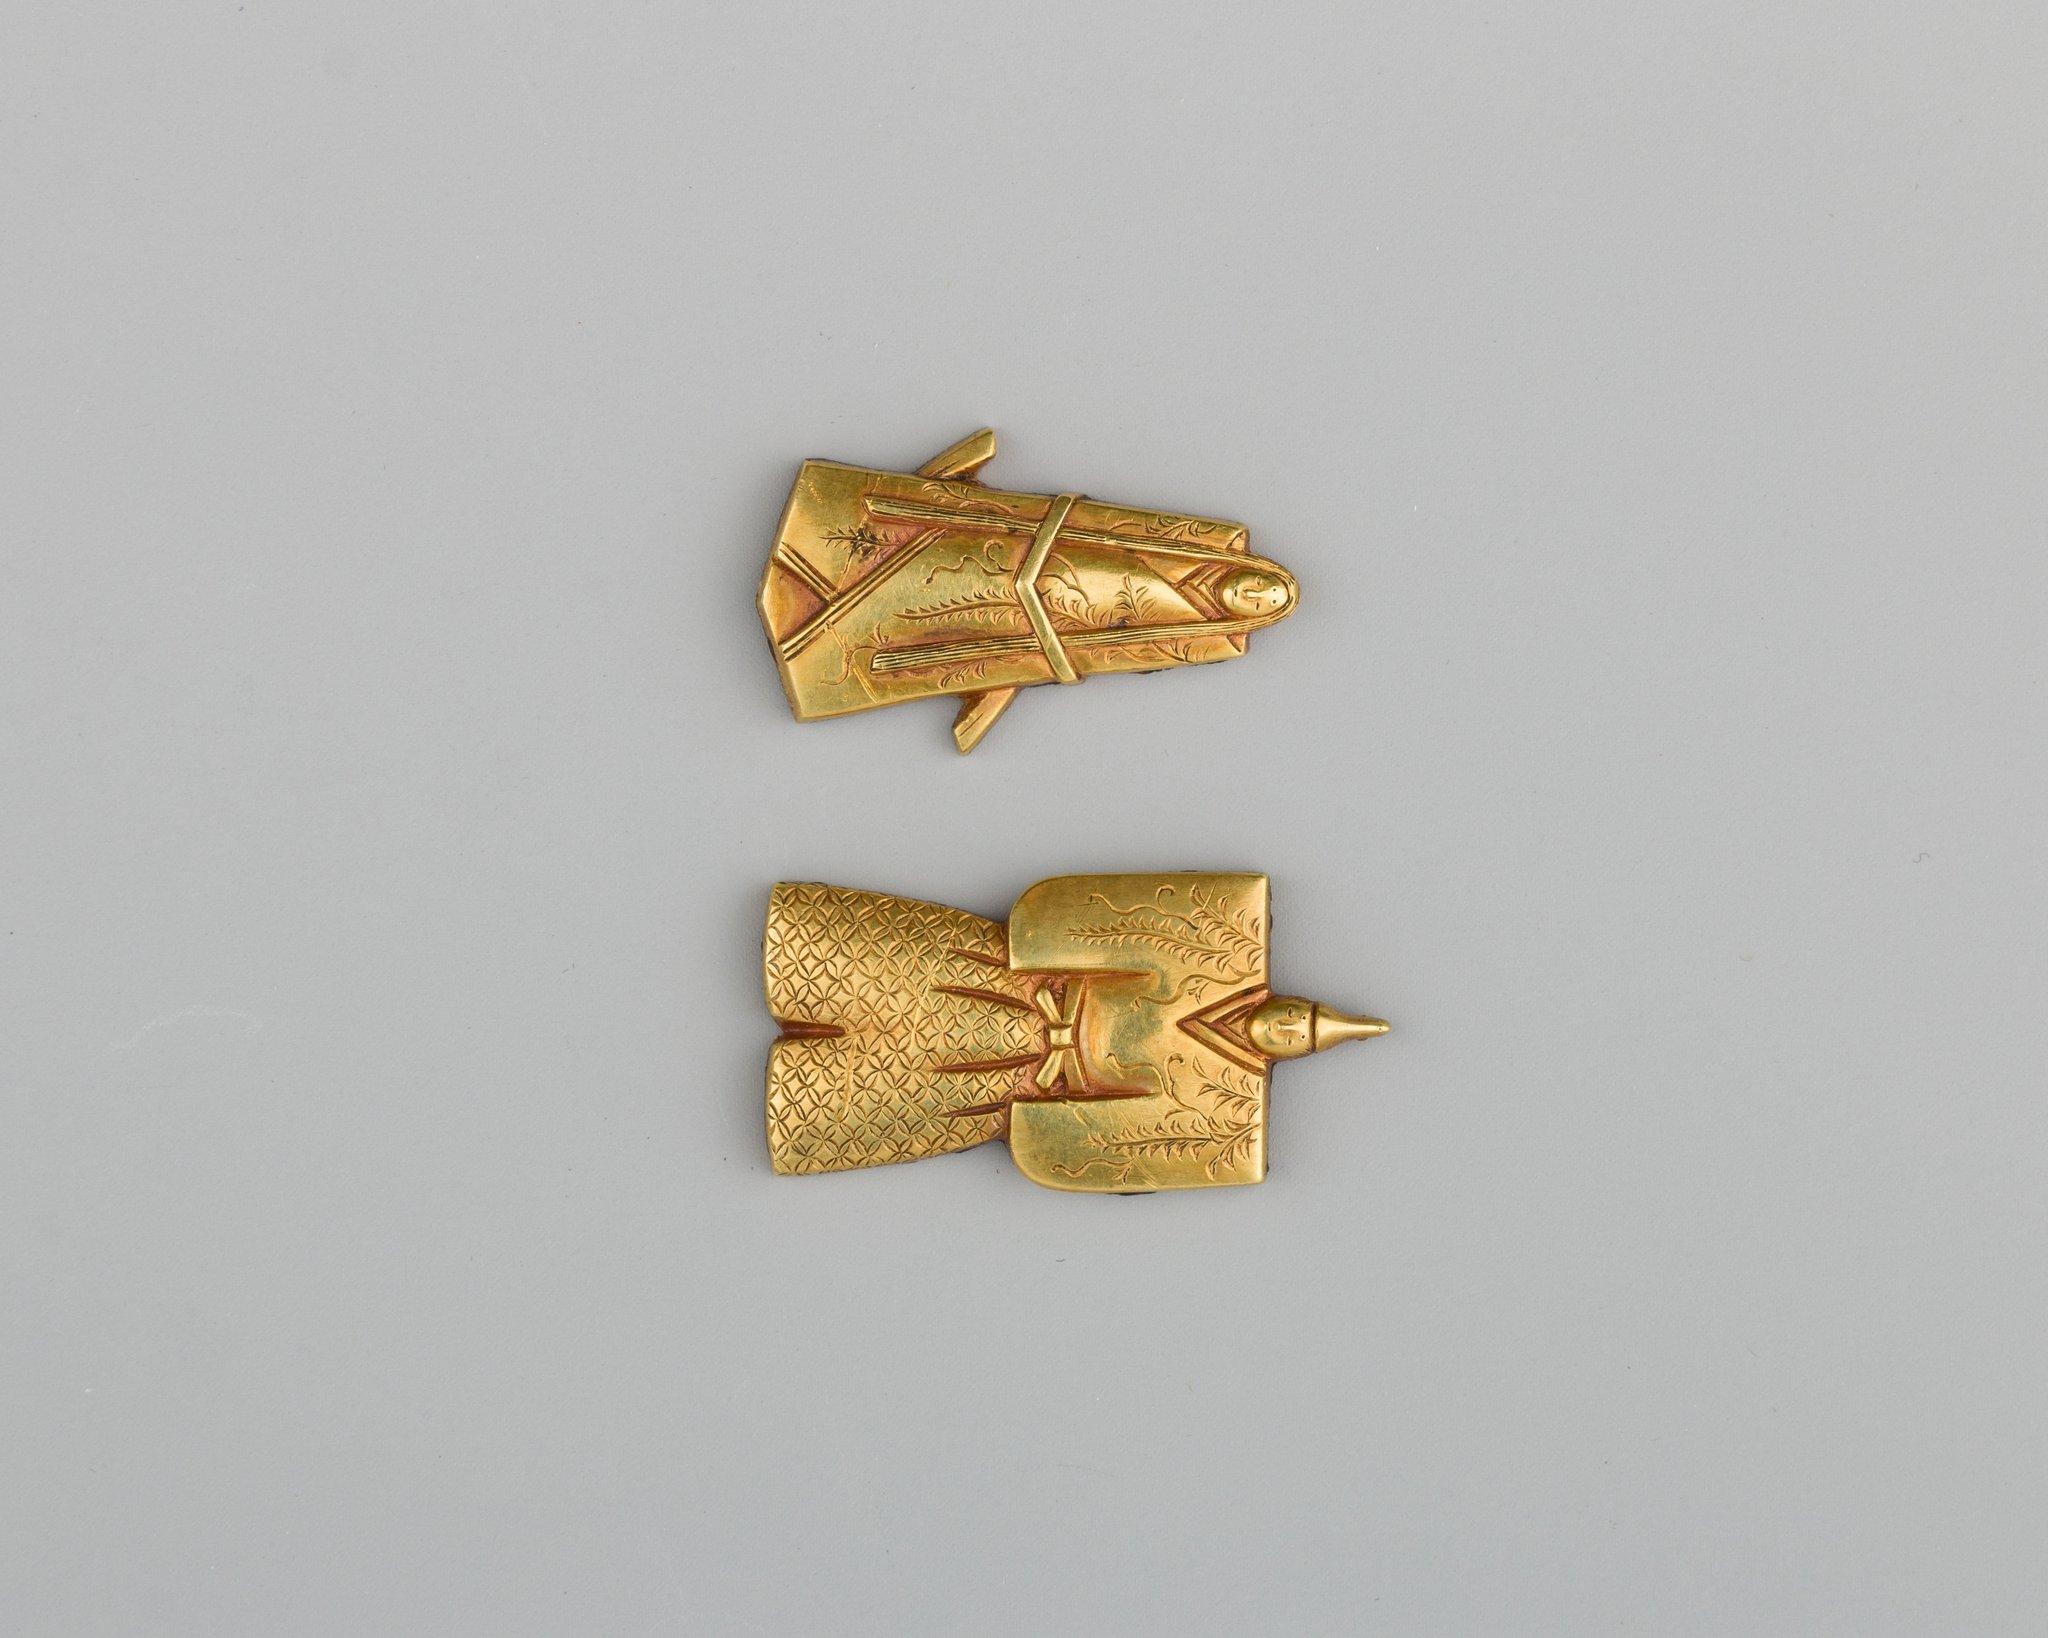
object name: pair of sword grip ornament menuki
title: Pair of Sword-Grip Ornaments (Menuki)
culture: japanese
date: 1701-1800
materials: gold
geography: japan